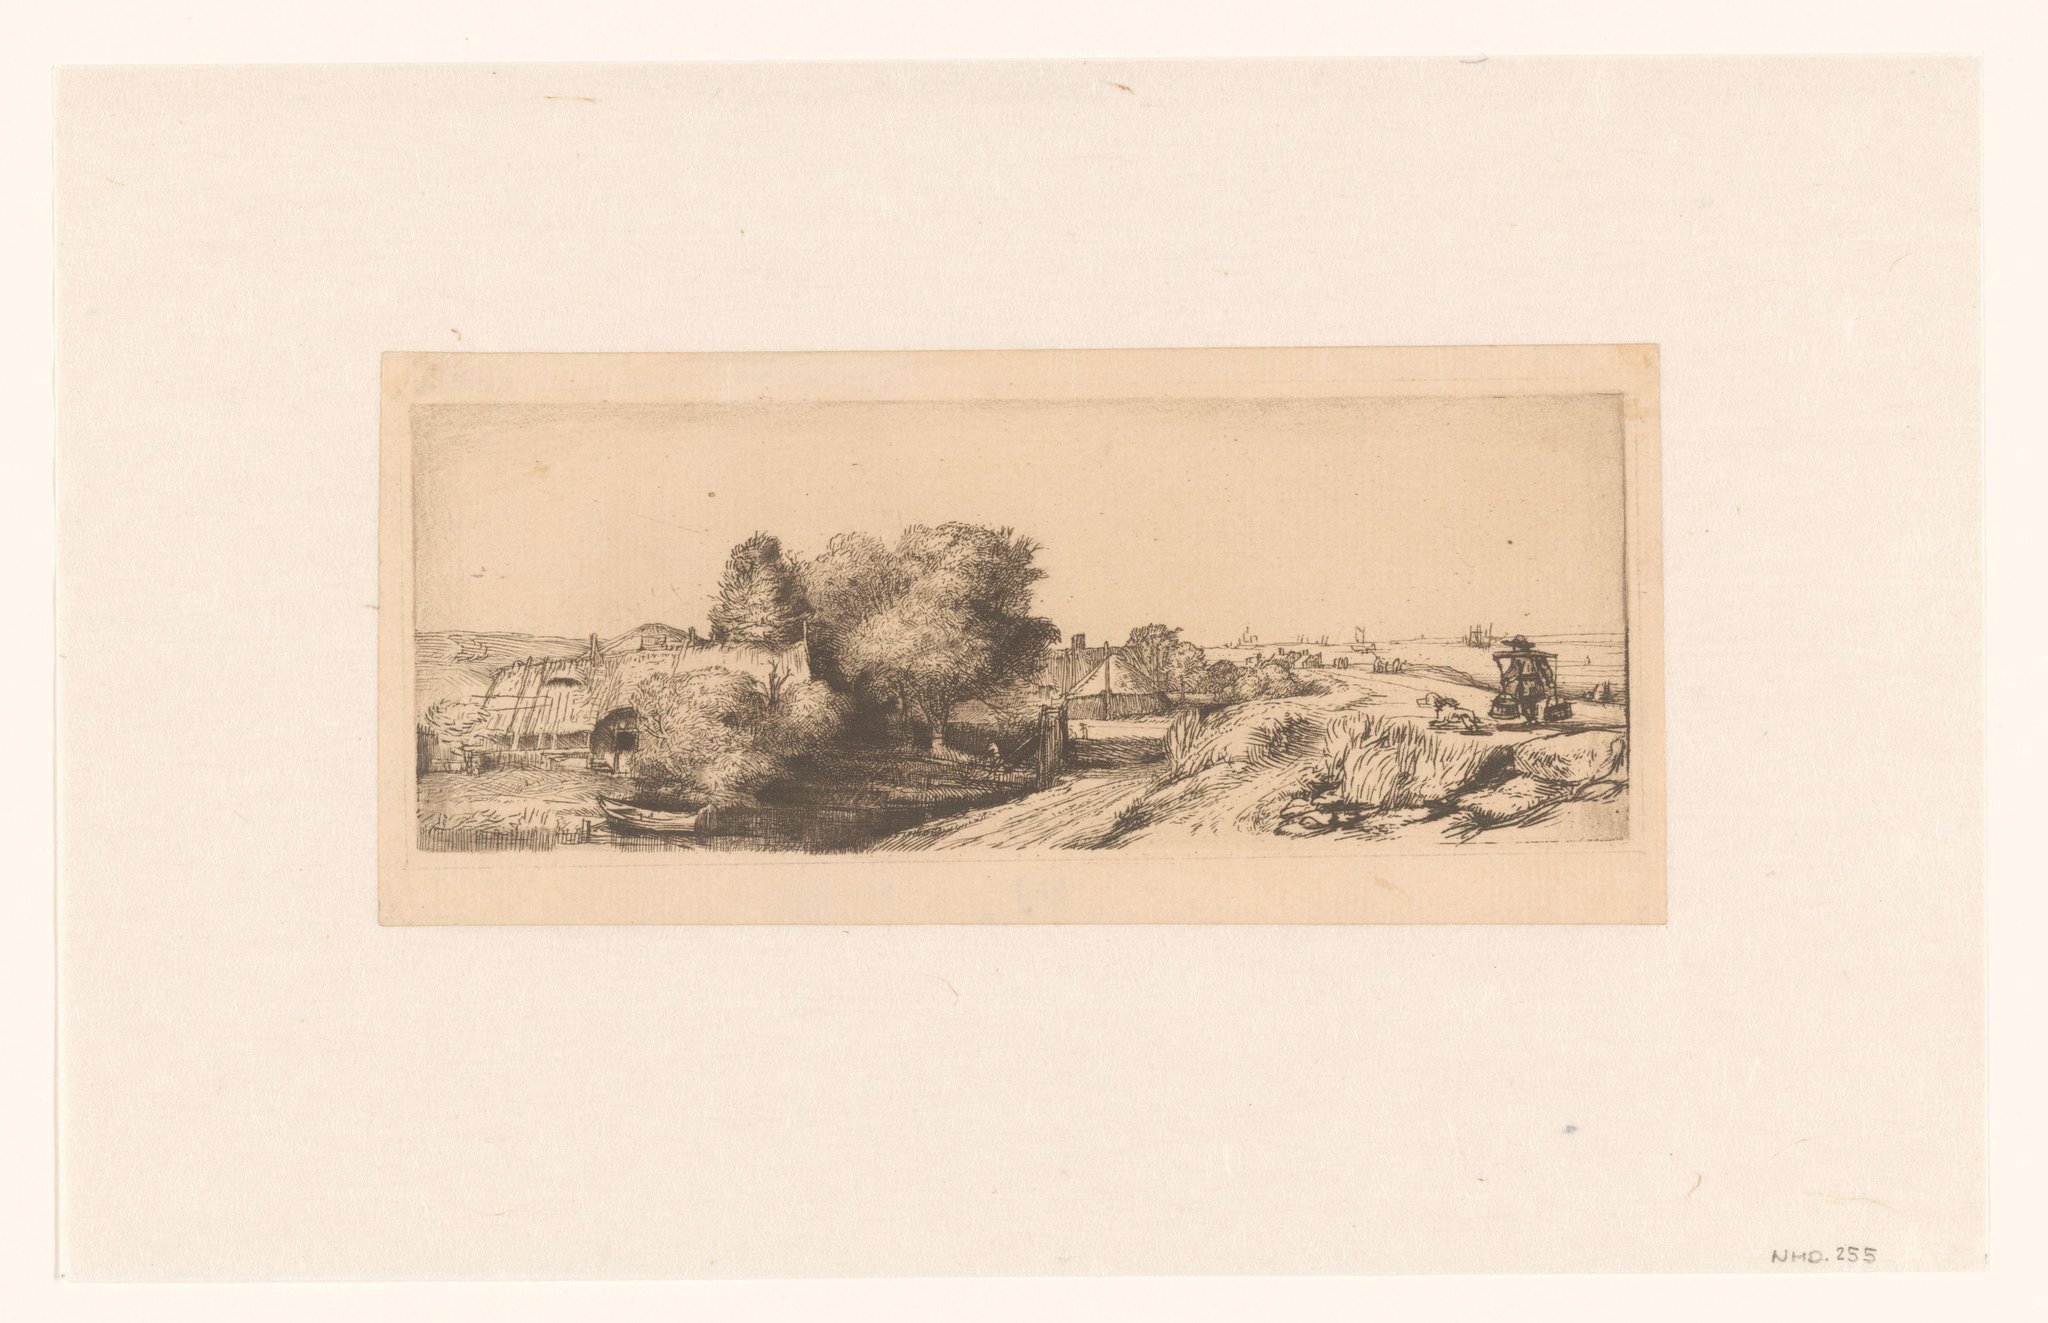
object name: print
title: View of the Diemerdijk with a milkman and cottages ('Het melkboertje')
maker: charles amand-durand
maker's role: print maker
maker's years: 1831-1905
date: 1841-1905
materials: paper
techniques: photoaquatint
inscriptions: collector's mark: Lugt 2934, collector's mark: Lugt 2228, collector's mark: Lugt 2760